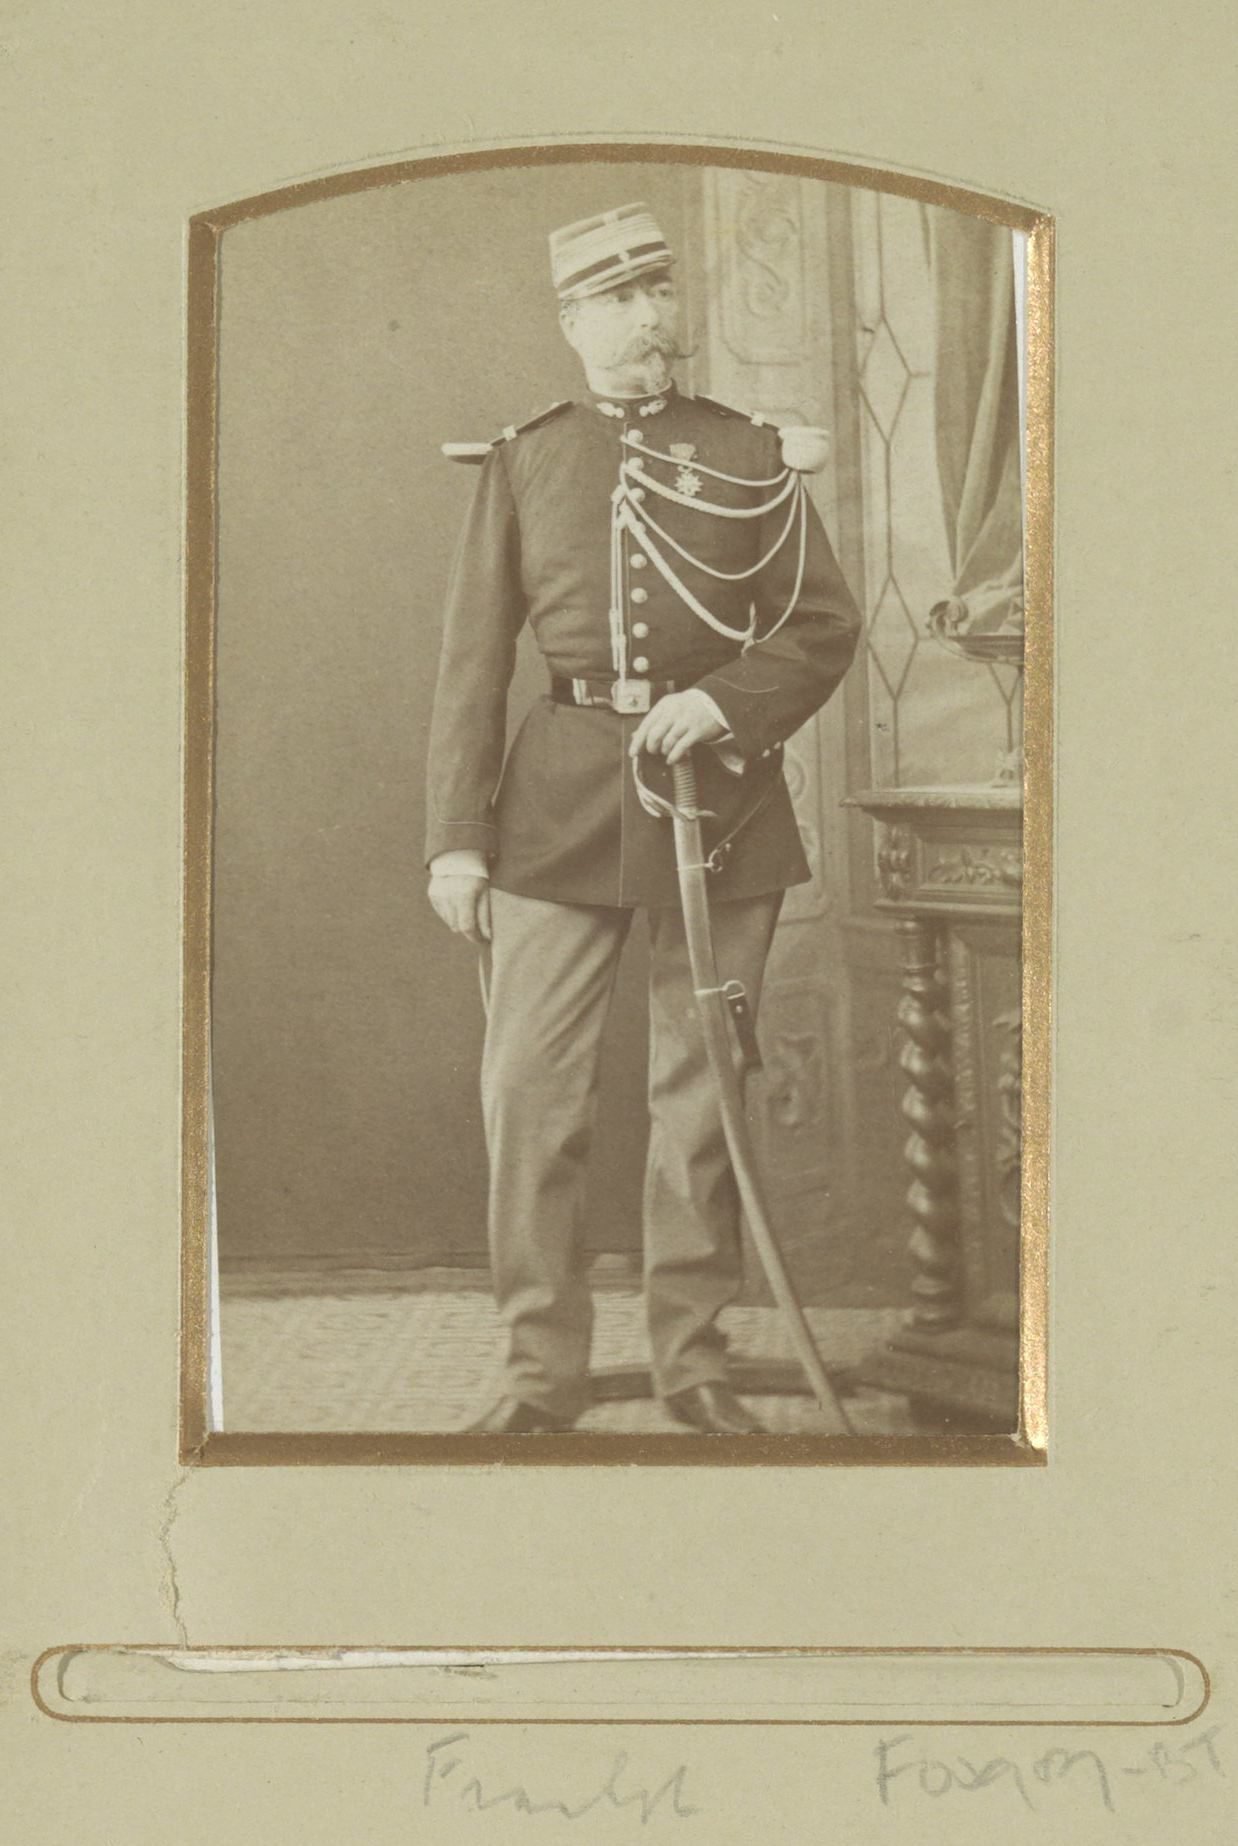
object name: photograph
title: Portret van een (vermoedelijk) Franse militair, staand met sabel in de hand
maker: léon cairol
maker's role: painter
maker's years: 1843-1895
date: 1870-1900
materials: cardboard, paper, photographic support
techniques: albumen print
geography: oran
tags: studio requisites ~ photographer, hacking and thrusting weapons (with name), warfare; military affairs, (military) uniforms, division of armed forces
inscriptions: inscription: ‘Collection M. Catto’, address: ‘Boulevard Oudinot Oran (Algérie)’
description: Onderdeel van Album met cartes-de-visite en kabinetfoto's van militairen in uniform.